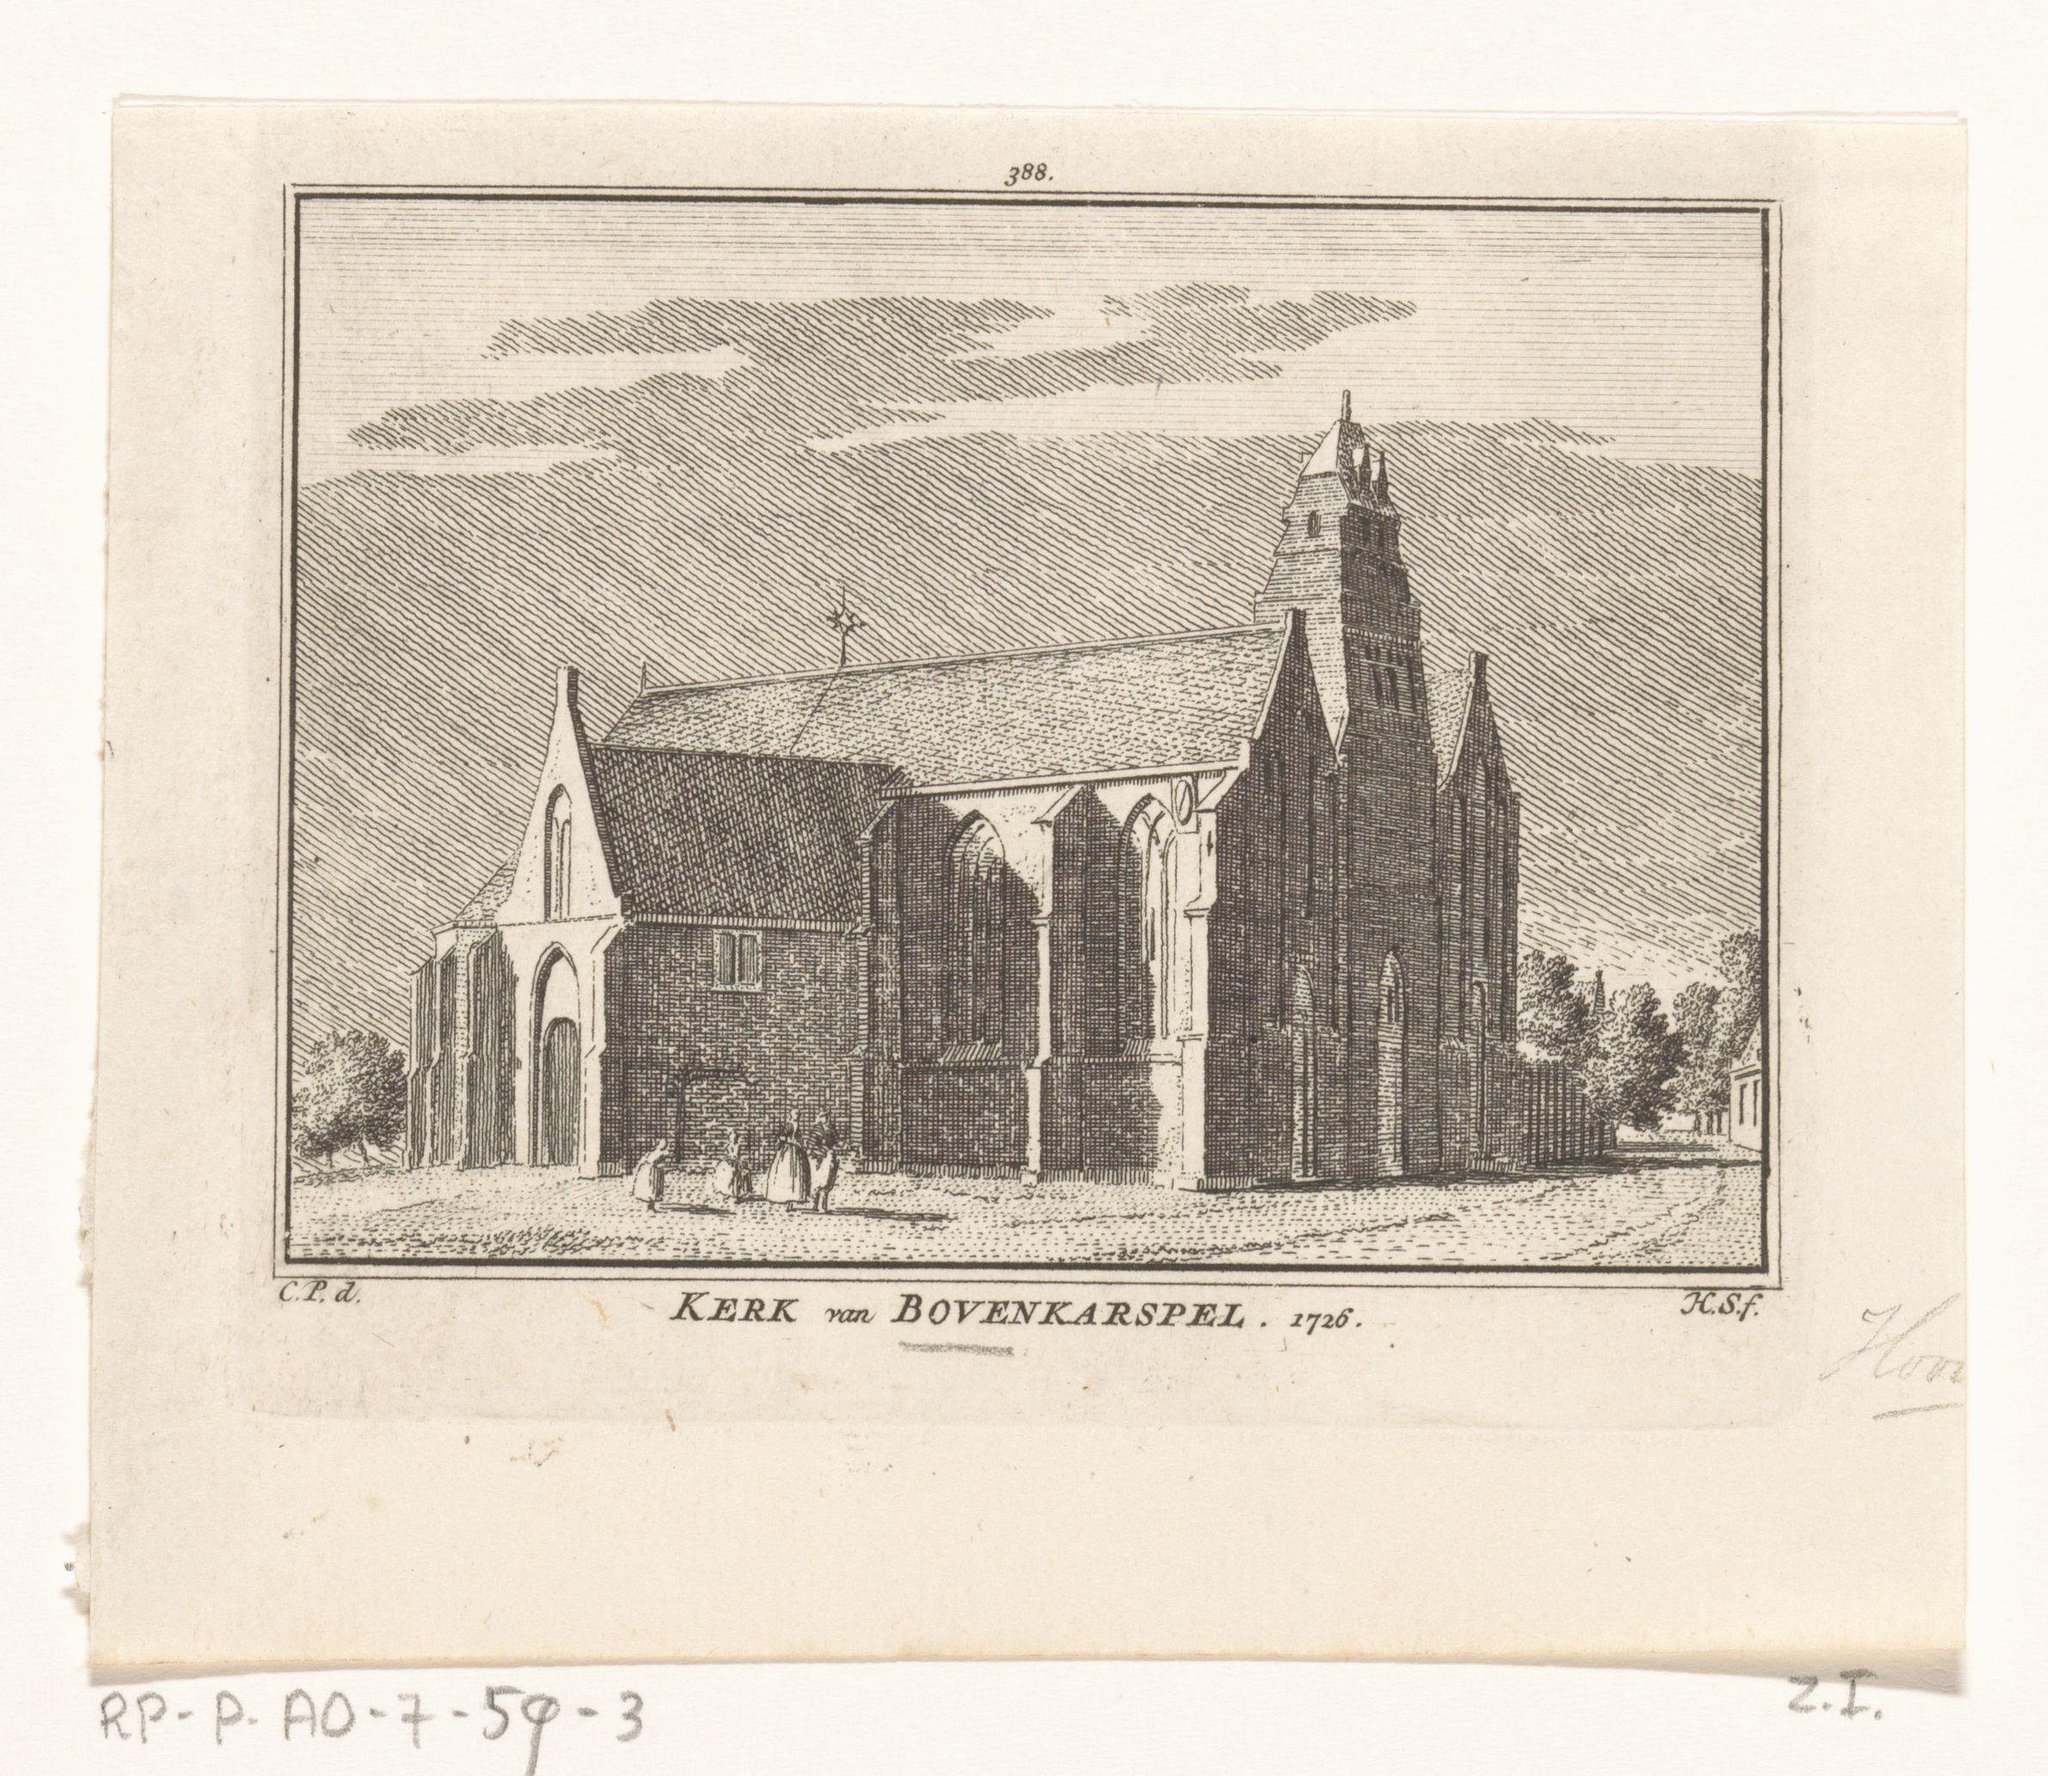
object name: book illustration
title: Gezicht op de kerk te Bovenkarspel, 1726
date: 1752-1792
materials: paper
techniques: engraving, etching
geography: haarlem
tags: church (exterior)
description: Prent ook gebruikt in: Het verheerlykt Nederland of kabinet van hedendaagsche gezigten van steden, dorpen (…). 9 delen. Amsterdam: Isaak Tirion en weduwe Isaak Tirion, 1745-1774, dl. 4 (1752), ill. 388. Of in: Nederlandsche tafereelen; of eene keurige verzameling van negen honderd fraaije gezigten van steden, dorpen, sloten, oudheden (….). 9 delen. Amsterdam: Jan de Groot, 1792, dl. 4, ill. 388. Uit welke druk het huidige exemplaar precies komt is niet na te gaan.